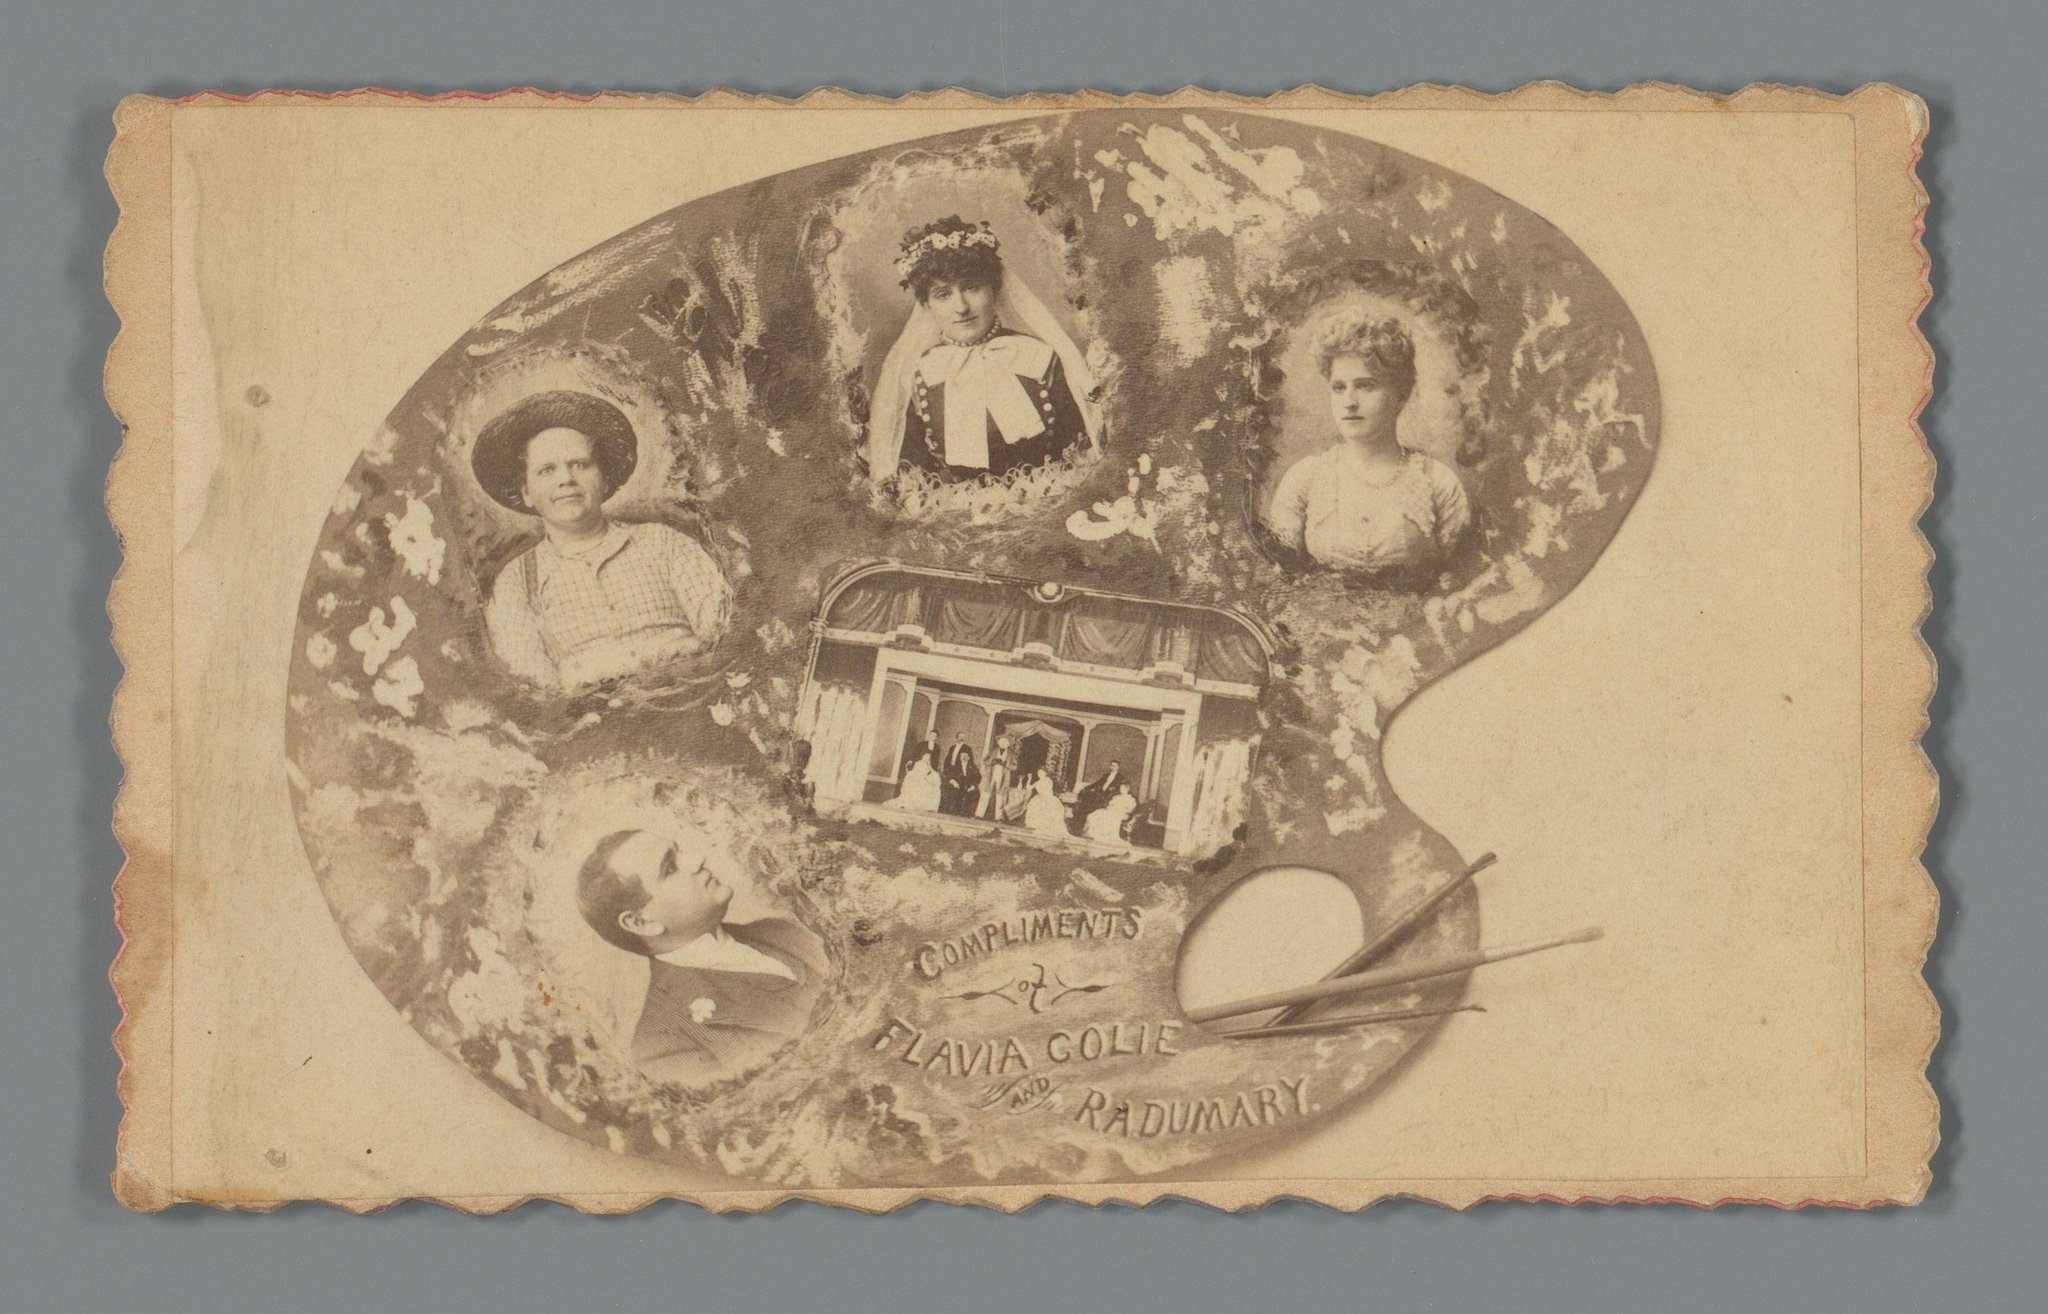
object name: carte de visite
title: Compliments of Flavia Colie and Radumary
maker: Anonymous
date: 1850-1915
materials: cardboard, photographic support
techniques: albumen print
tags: advertising, historical persons not known by name - bb - woman, portrait of actor, actress, palette